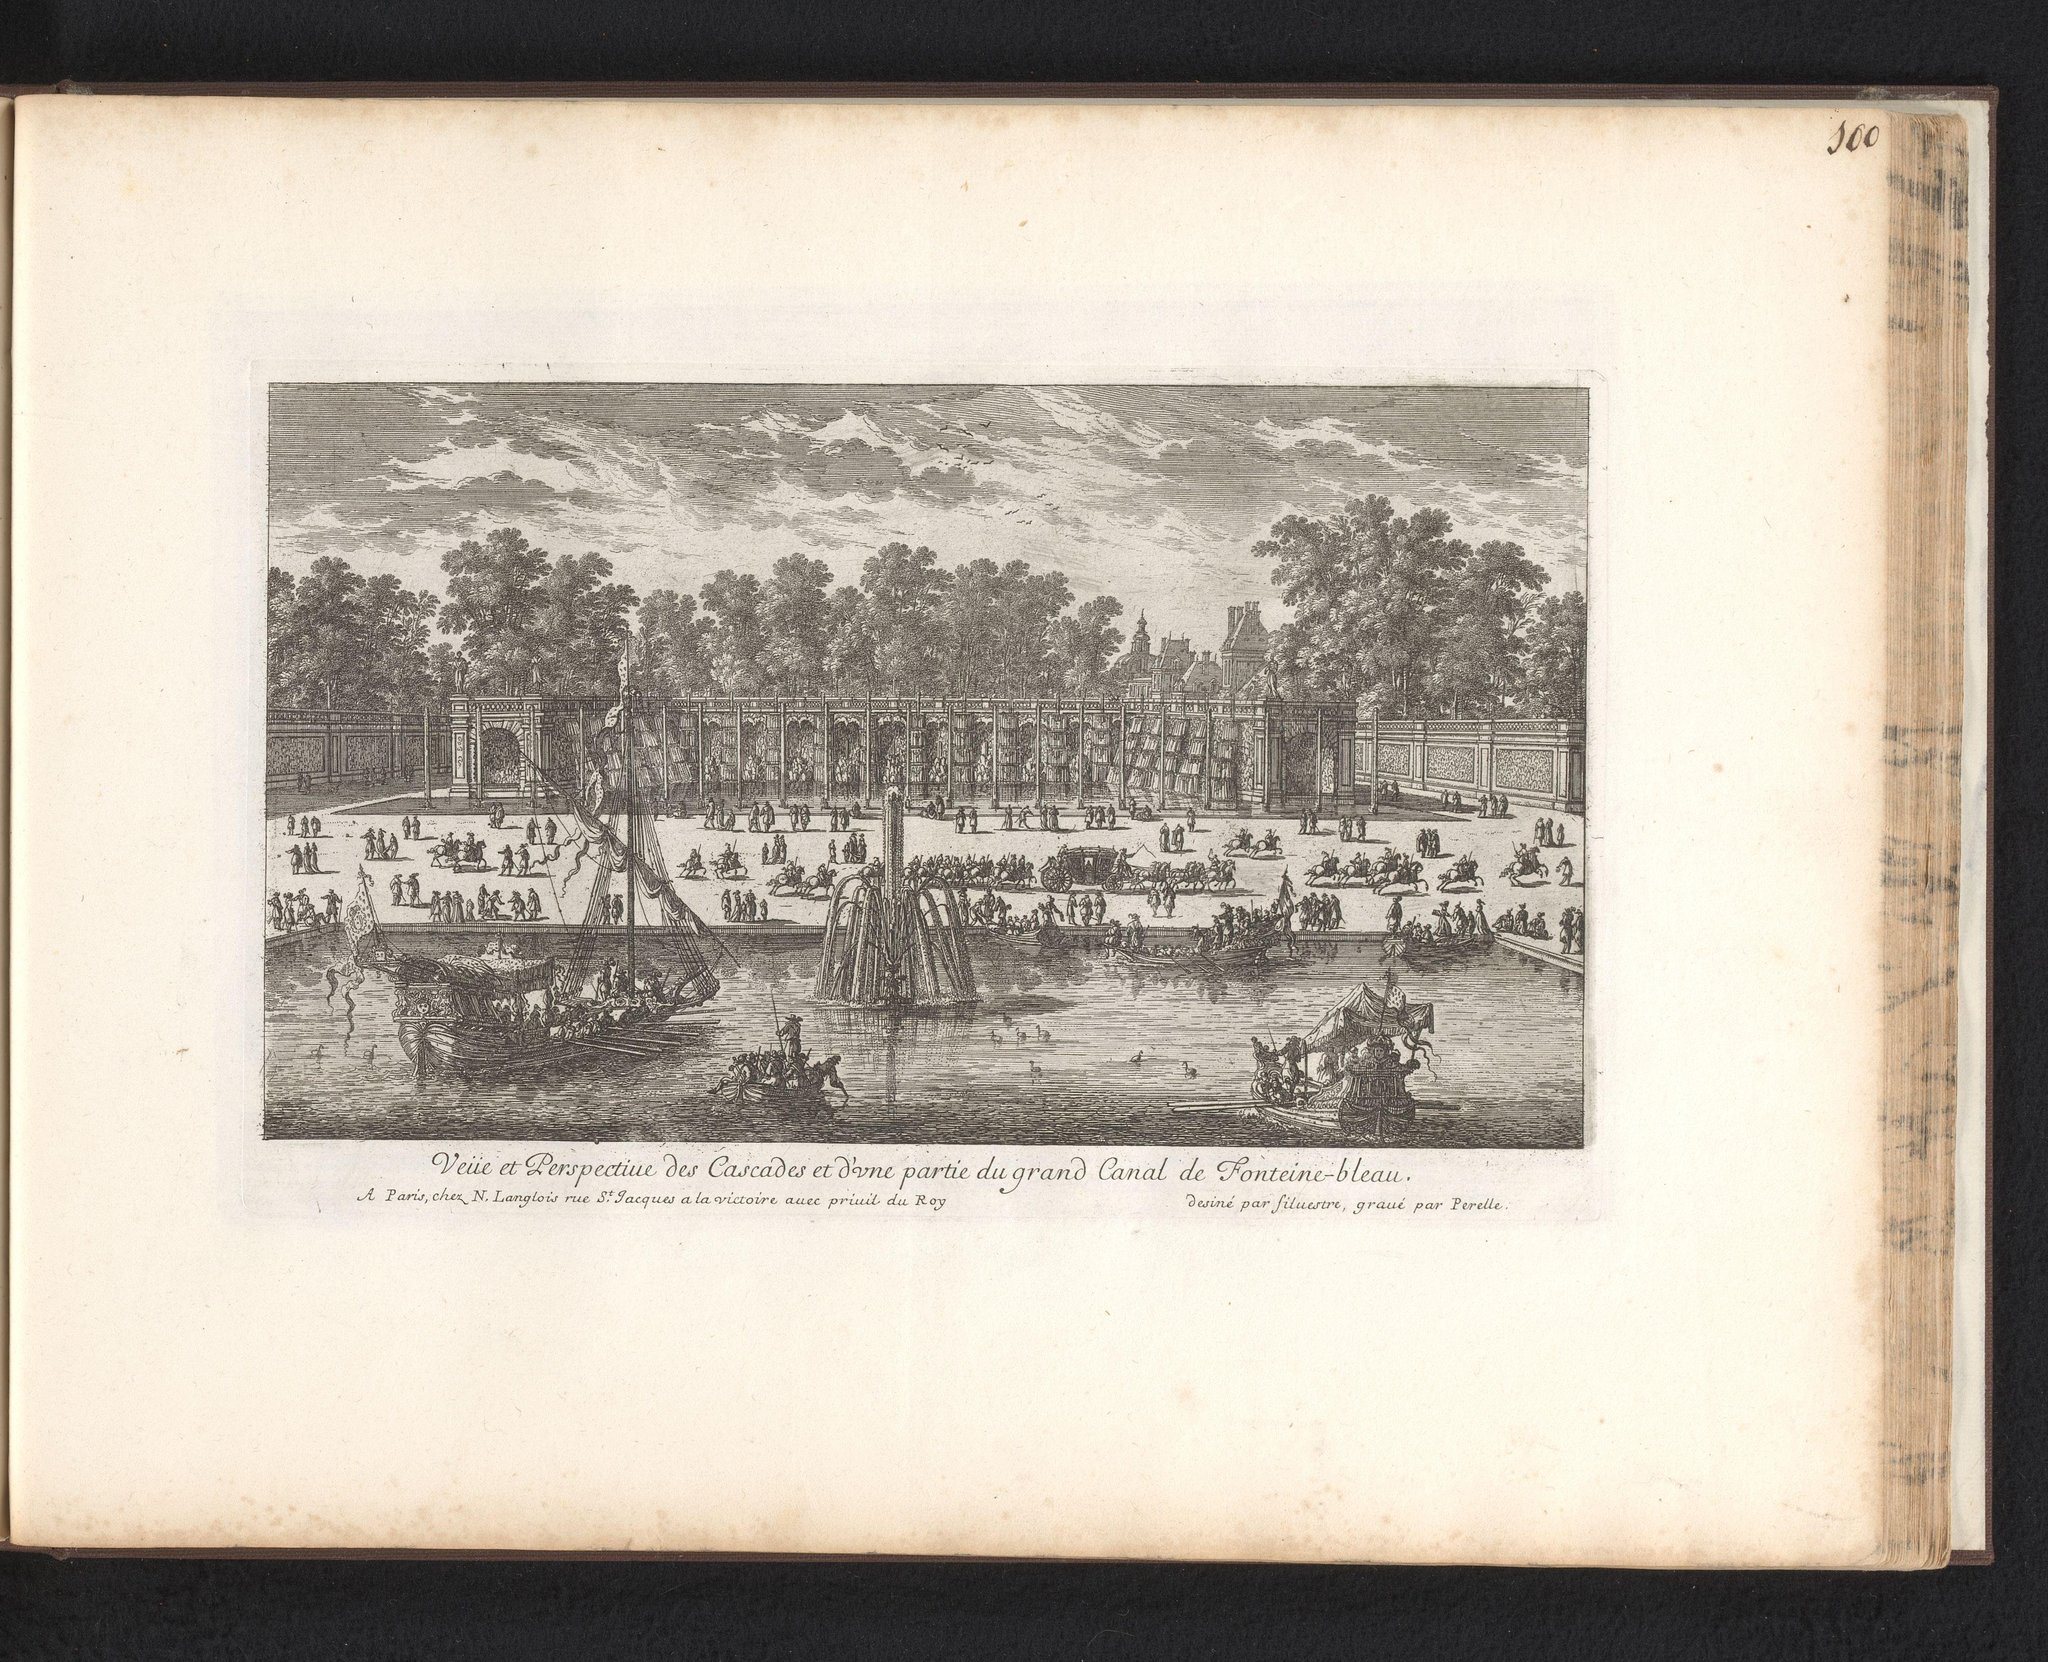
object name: album leaf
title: Gezicht op de watervallen van kasteel Fontainebleau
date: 1640-1691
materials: paper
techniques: etching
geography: france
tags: french or architectonic garden; formal garden, garden cascade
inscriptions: collector's mark: Lugt 2228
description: Prenten met het signatuur 'Perelle' kunnen zowel door vader Gabriel als door zonen Nicolas en Adam gemaakt zijn. De uitgevers vader en zoon Nicolas Langlois worden allebei vermeld als N. Langlois op hetzelfde adres.